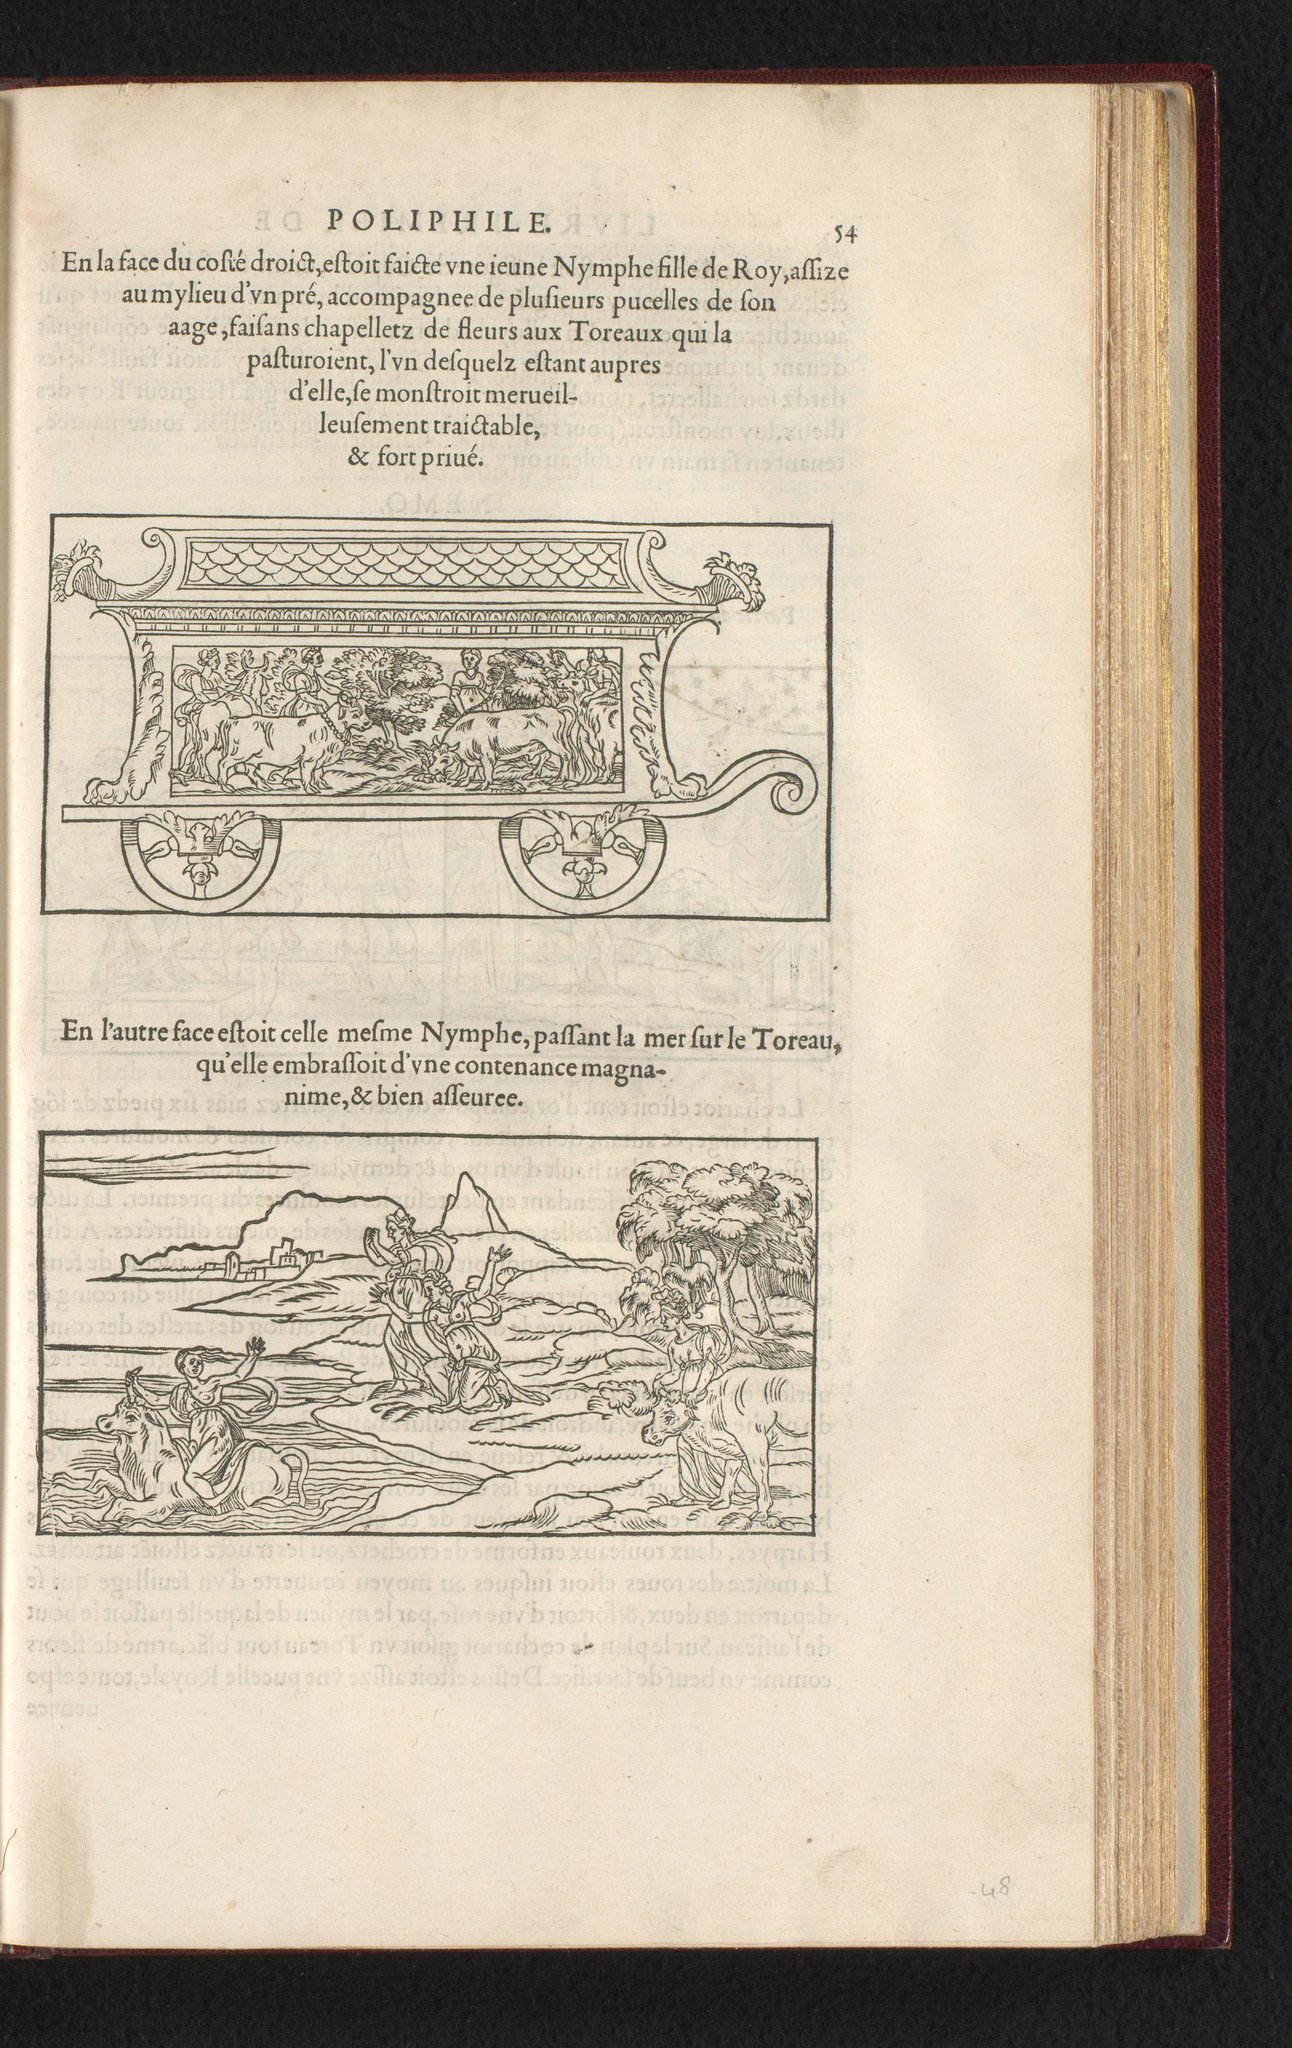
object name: book illustration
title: Zijaanzicht van een triomfwagen met vrouwen en stieren, en detail met de roof van Europa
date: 1546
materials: paper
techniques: letterpress printing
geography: paris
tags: jupiter, usually in the shape of a white bull, abducts europa and carries her across the water, bull, chariot, triumphal car, (scenes from) specific works of literature: colonna, hypnerotomachia poliphili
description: Prent uit: Colonna, Francesco. Hypnerotomachie ou discours du songe de Poliphile, deduisant comme amour le combat a l'occasion de Polia. Parijs: Jacques Kerver, 1546, recto fol. 54.